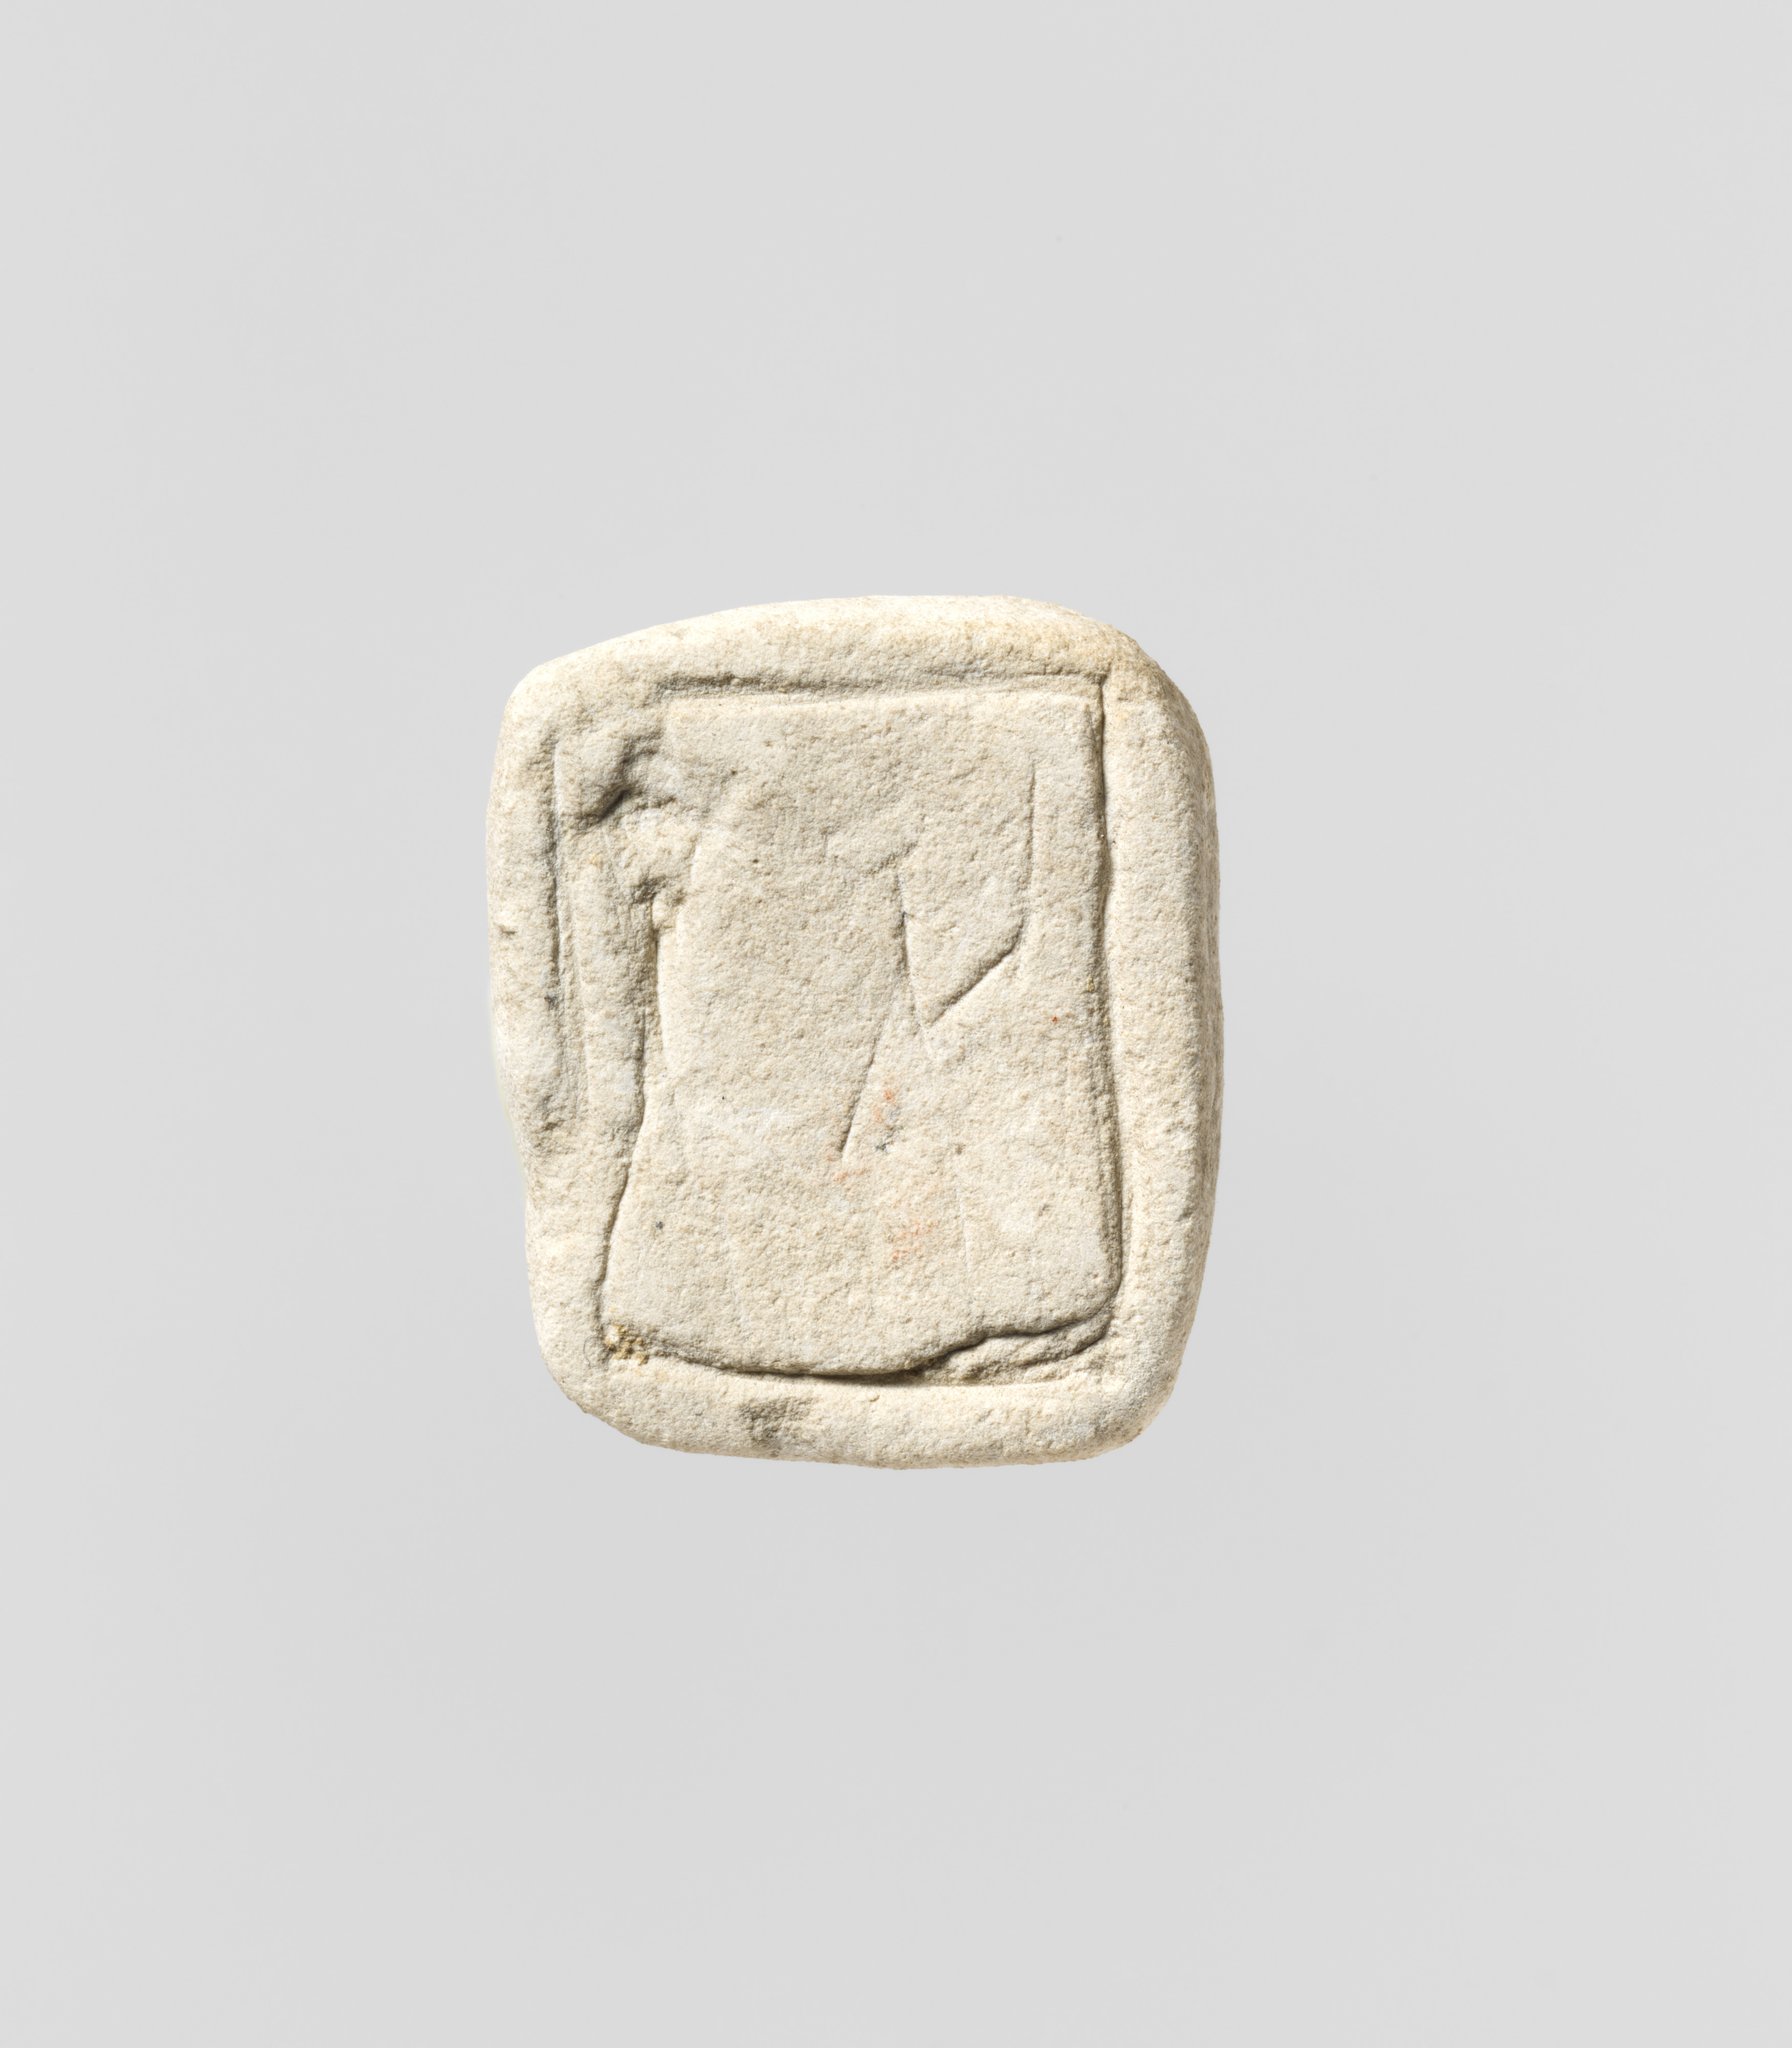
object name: stamp seal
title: Stamp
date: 1295-1070 BCE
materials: limestone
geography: egypt